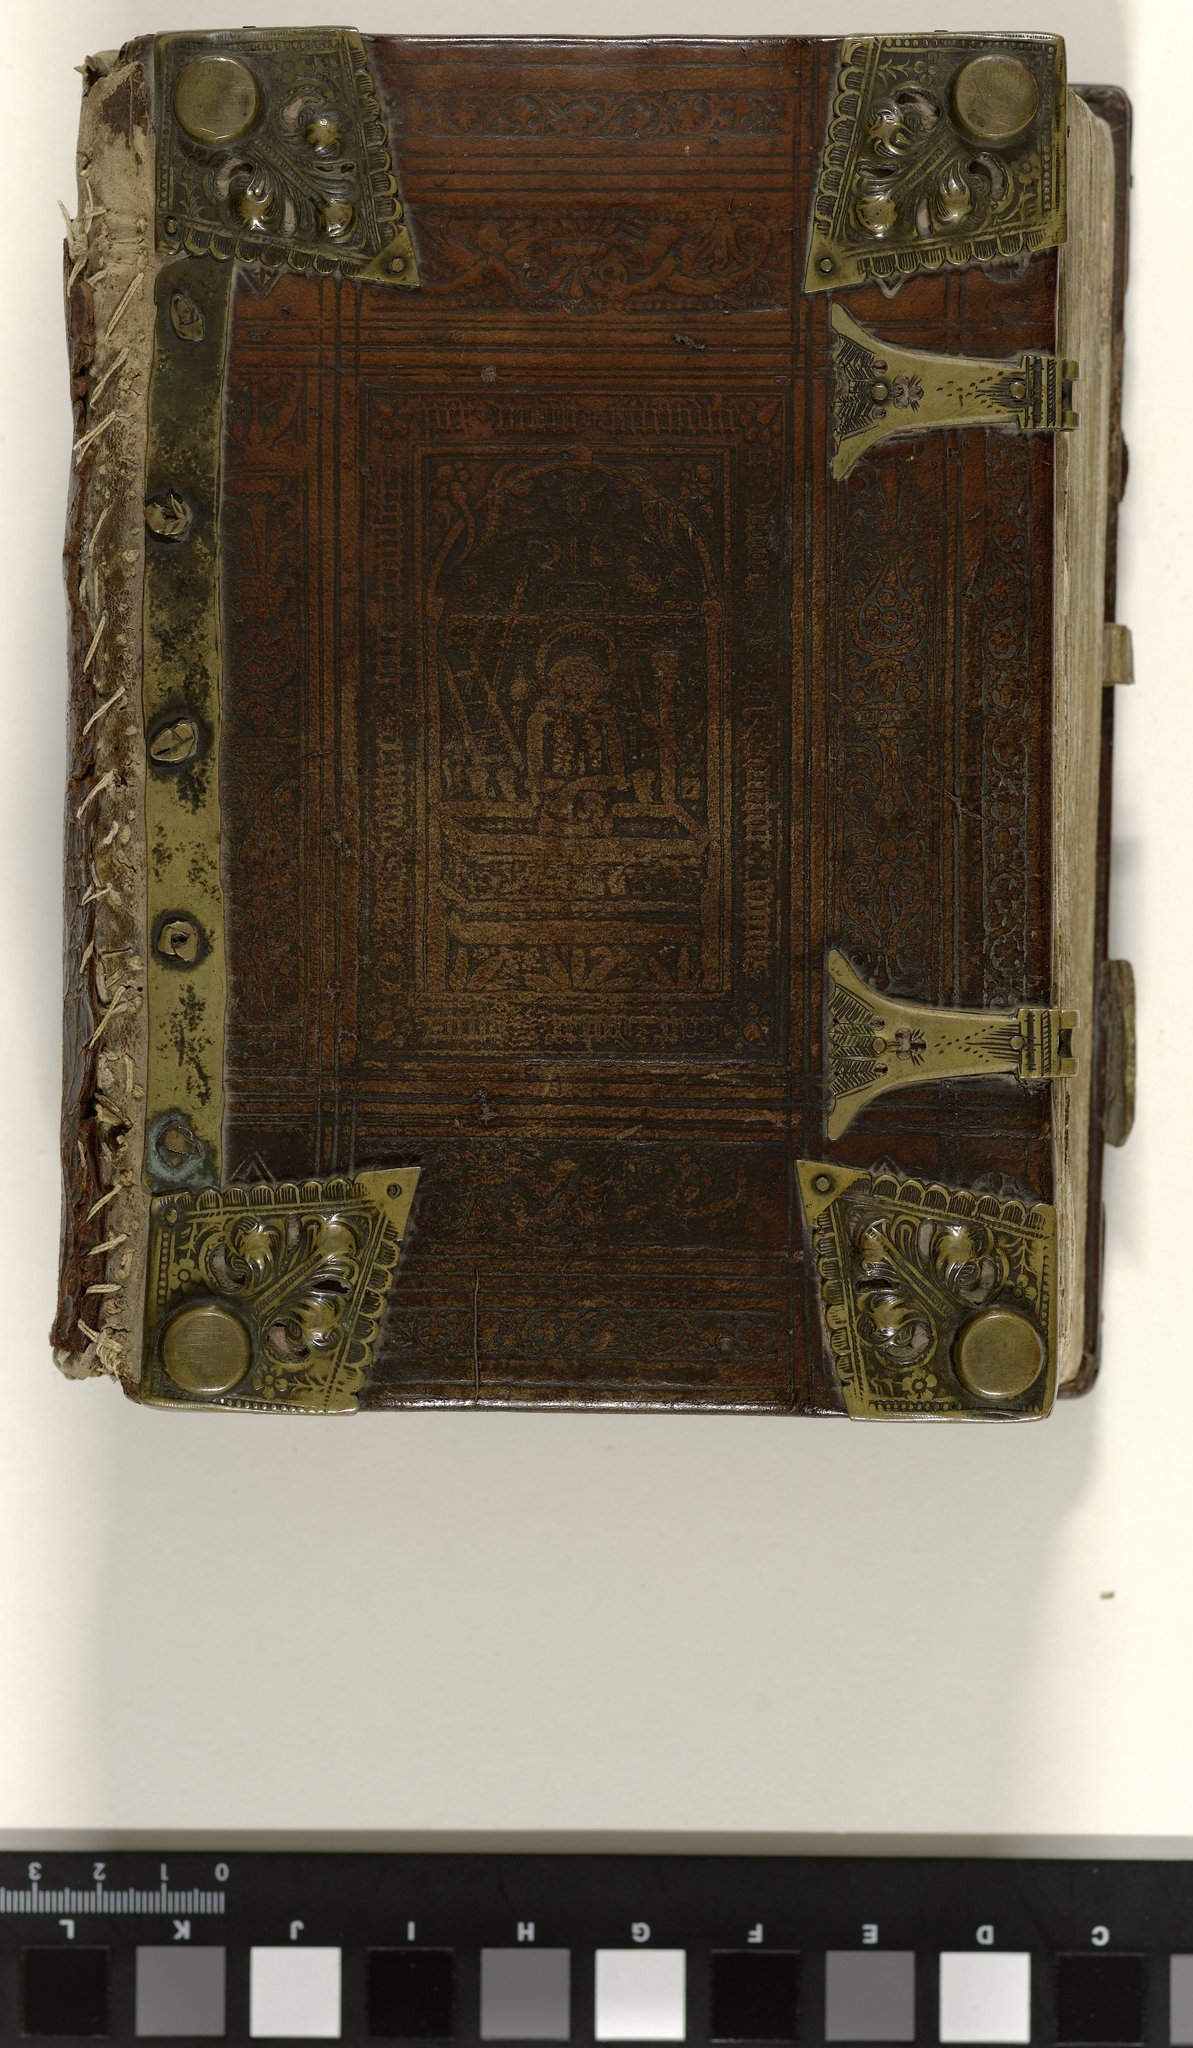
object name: drawing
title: Psalter en brevier (gedeeltes) in het Latijn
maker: Anonymous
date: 1500-1600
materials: paint, paper, parchment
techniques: pen in colors, brush in colors